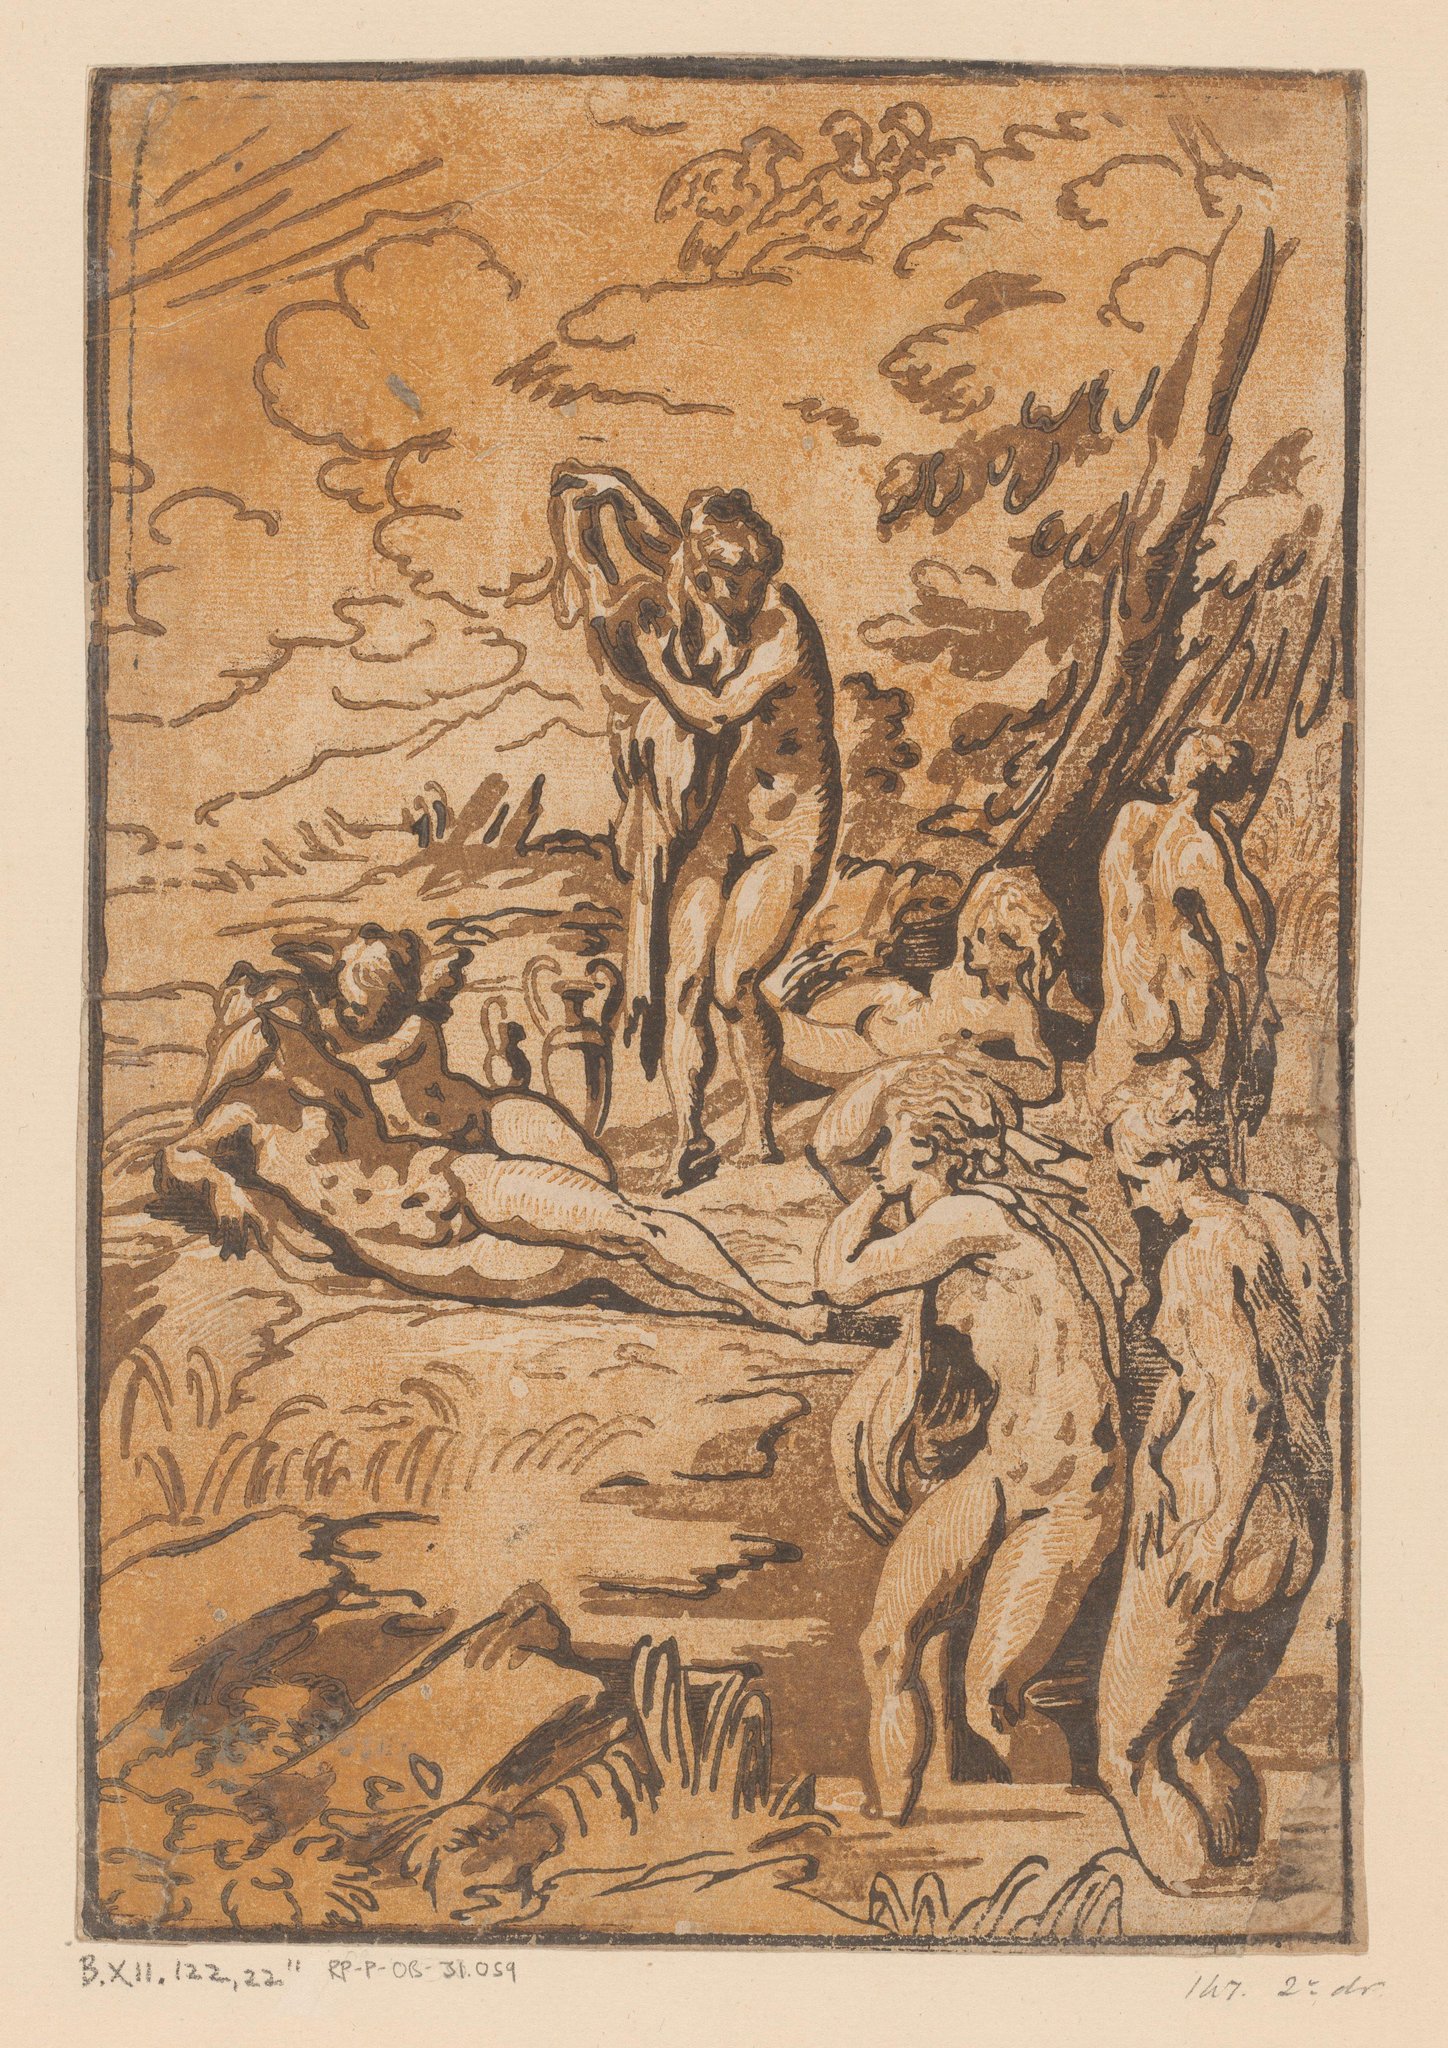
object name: print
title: Badende nimfen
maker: ugo da carpi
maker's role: painter, print maker, printer, publisher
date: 1502-1532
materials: paper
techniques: woodcut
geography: italy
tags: nymphs (in general); 'ninfe in commune' (ripa), washing and bathing - aa - in the open air, cupids: 'amores', 'amoretti', 'putti'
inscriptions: collector's mark: Lugt 240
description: Naakte nimfen badend in een rivier. Links een putto bij een van de nimfen.